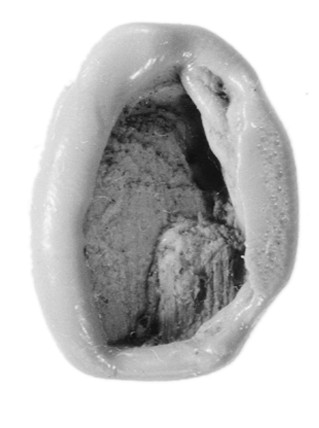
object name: sealing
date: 2030-1640 BCE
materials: clay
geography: egypt